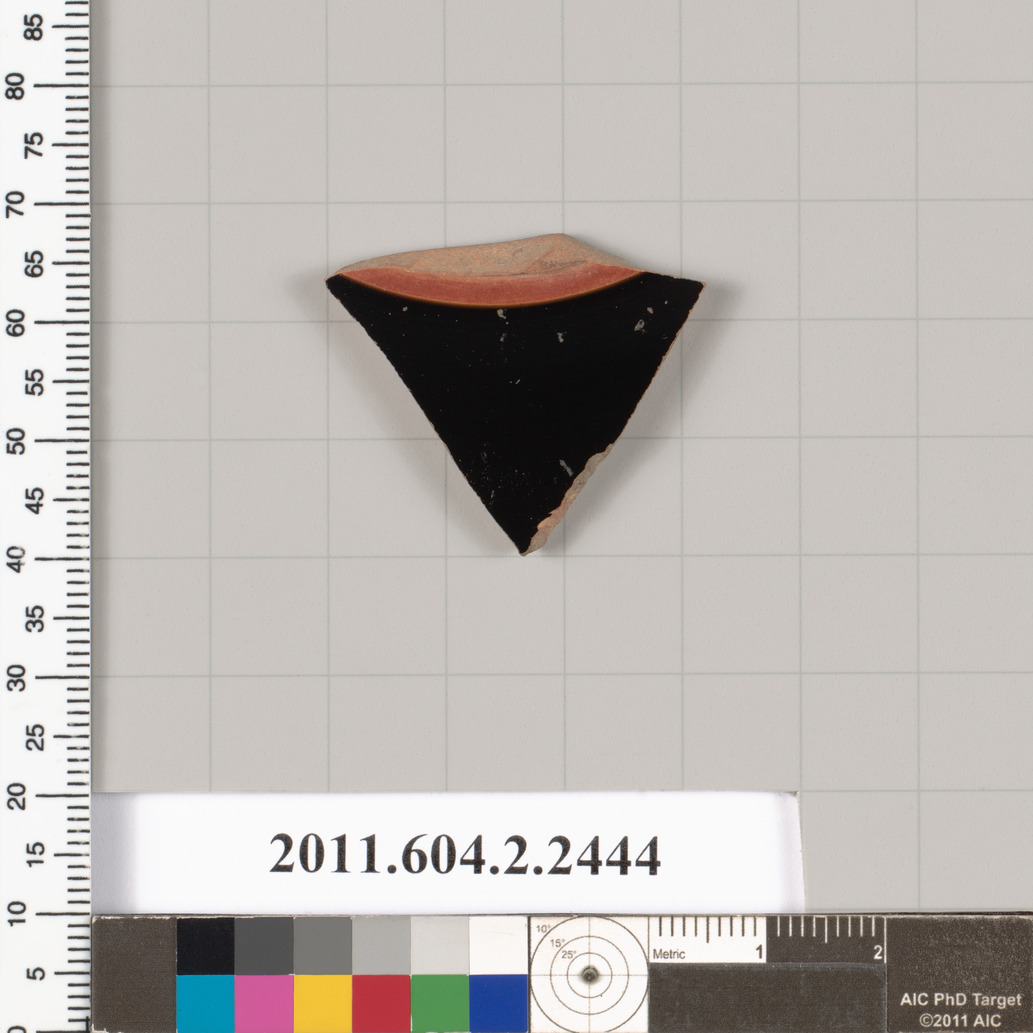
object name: plate fragment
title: Terracotta fragment of a plate?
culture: greek, attic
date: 475-451 BCE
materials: terracotta